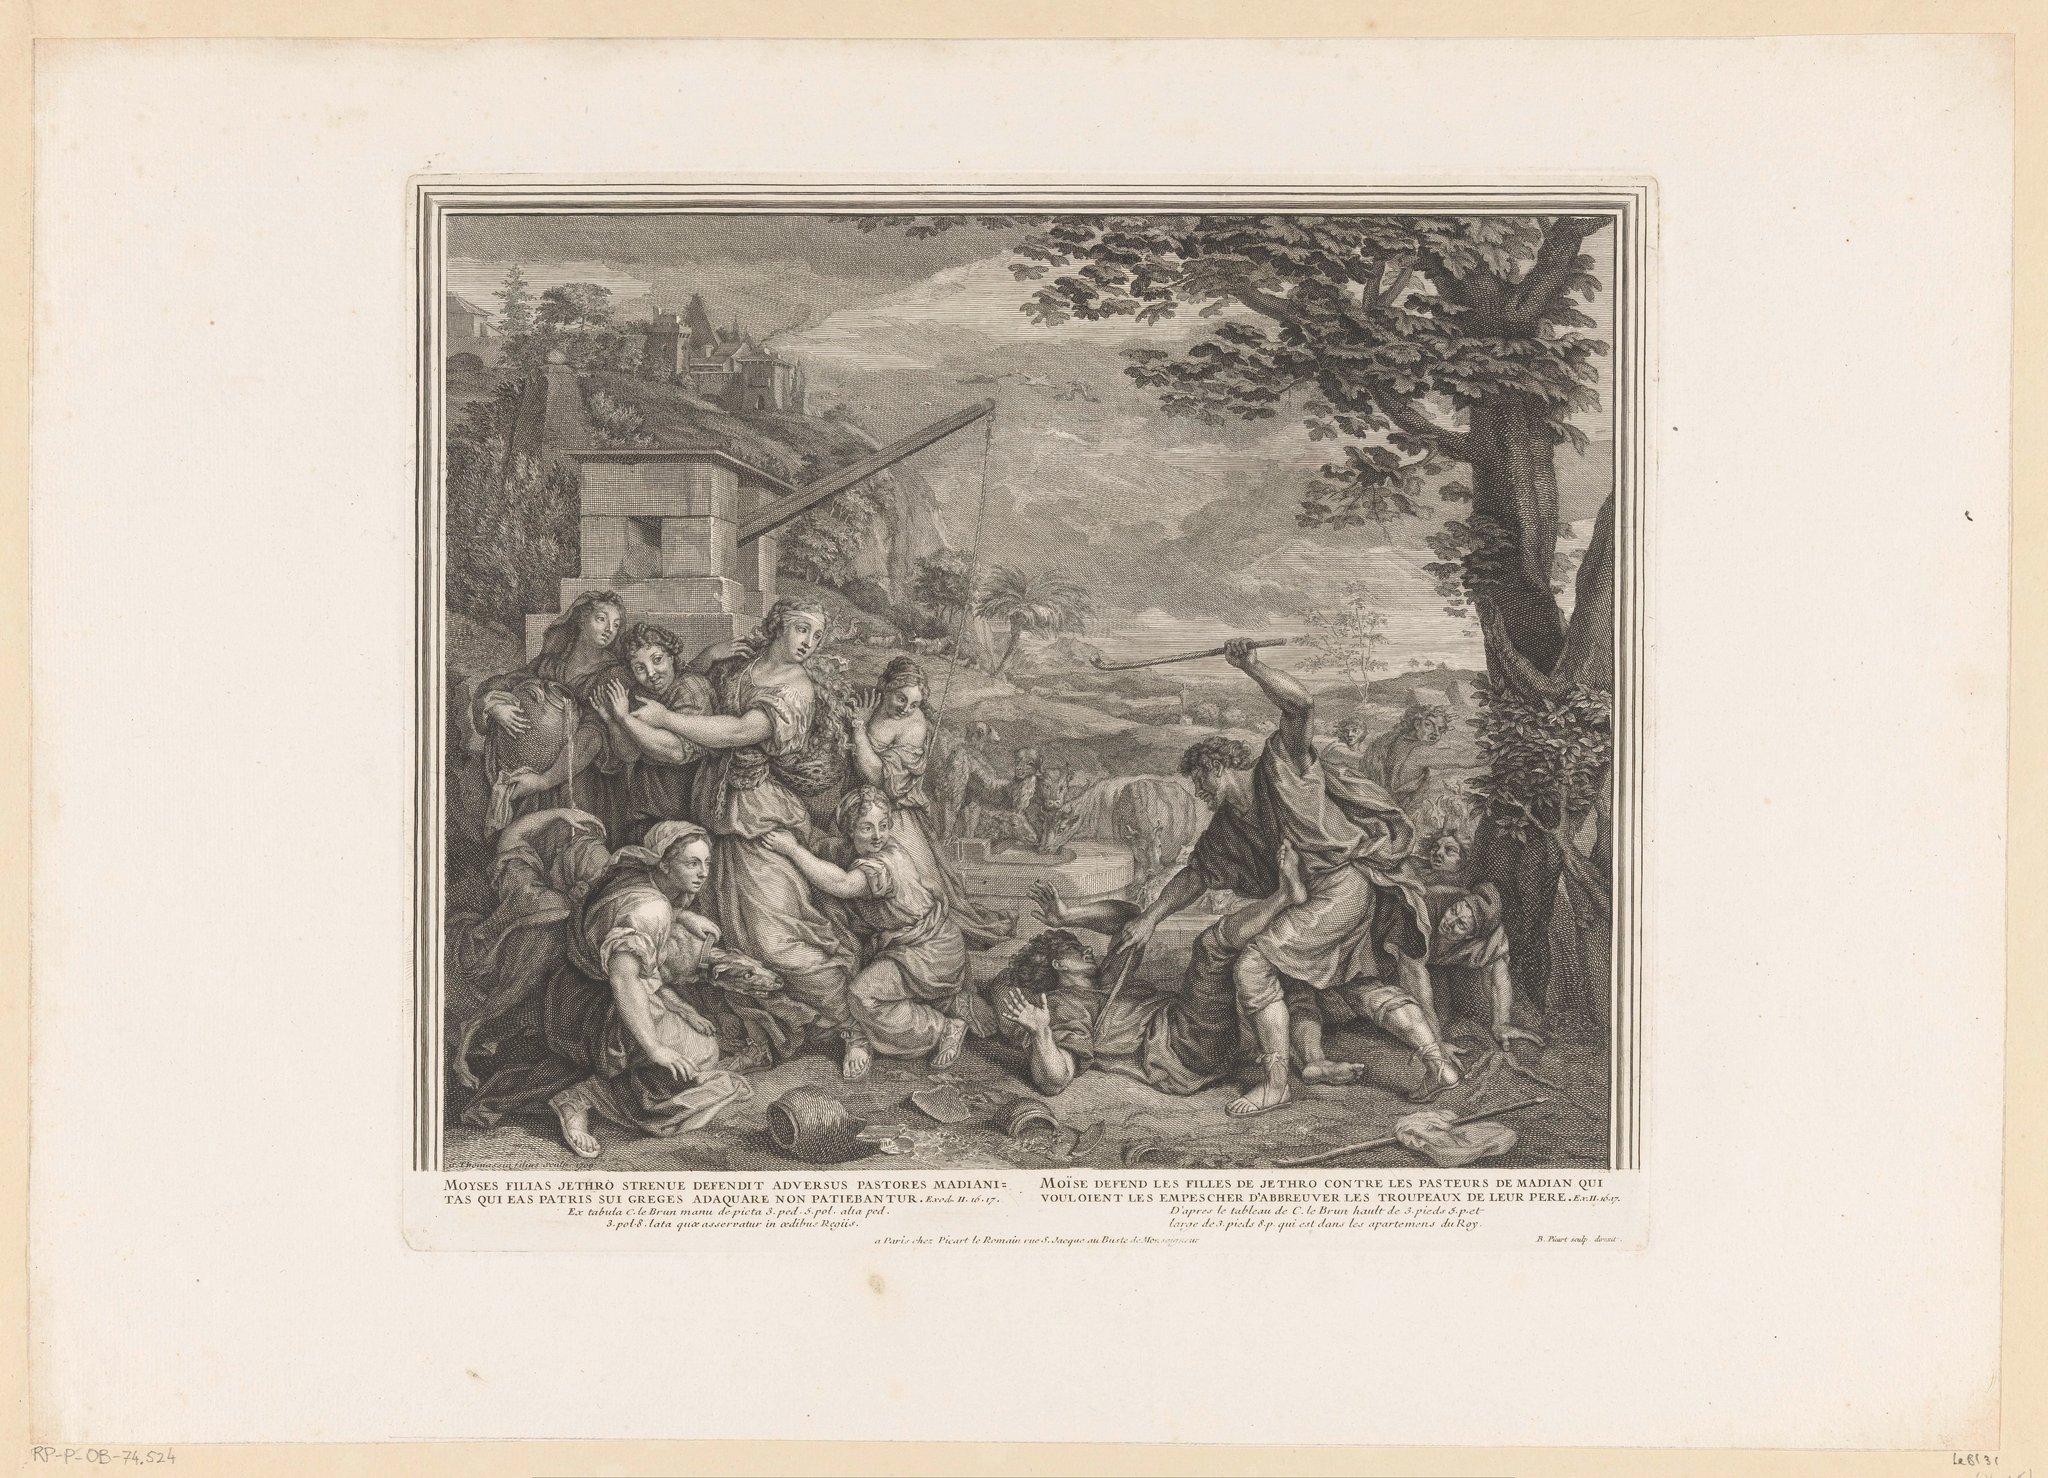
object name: print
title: Mozes en de dochters van Reüel (Jetro) bij de put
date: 1709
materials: paper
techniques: engraving, etching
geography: paris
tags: well, cattle, moses drives away the shepherds who wanted to prevent jethro's daughters from watering their father's flock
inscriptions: collector's mark: Lugt 2228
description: Aan de rechterzijde schiet Mozes de zeven dochters van Reüel (Jetro) te hulp en verjaagt de herders bij de waterput. Het vee van Reüel op de achtergrond drinkt uit de put.